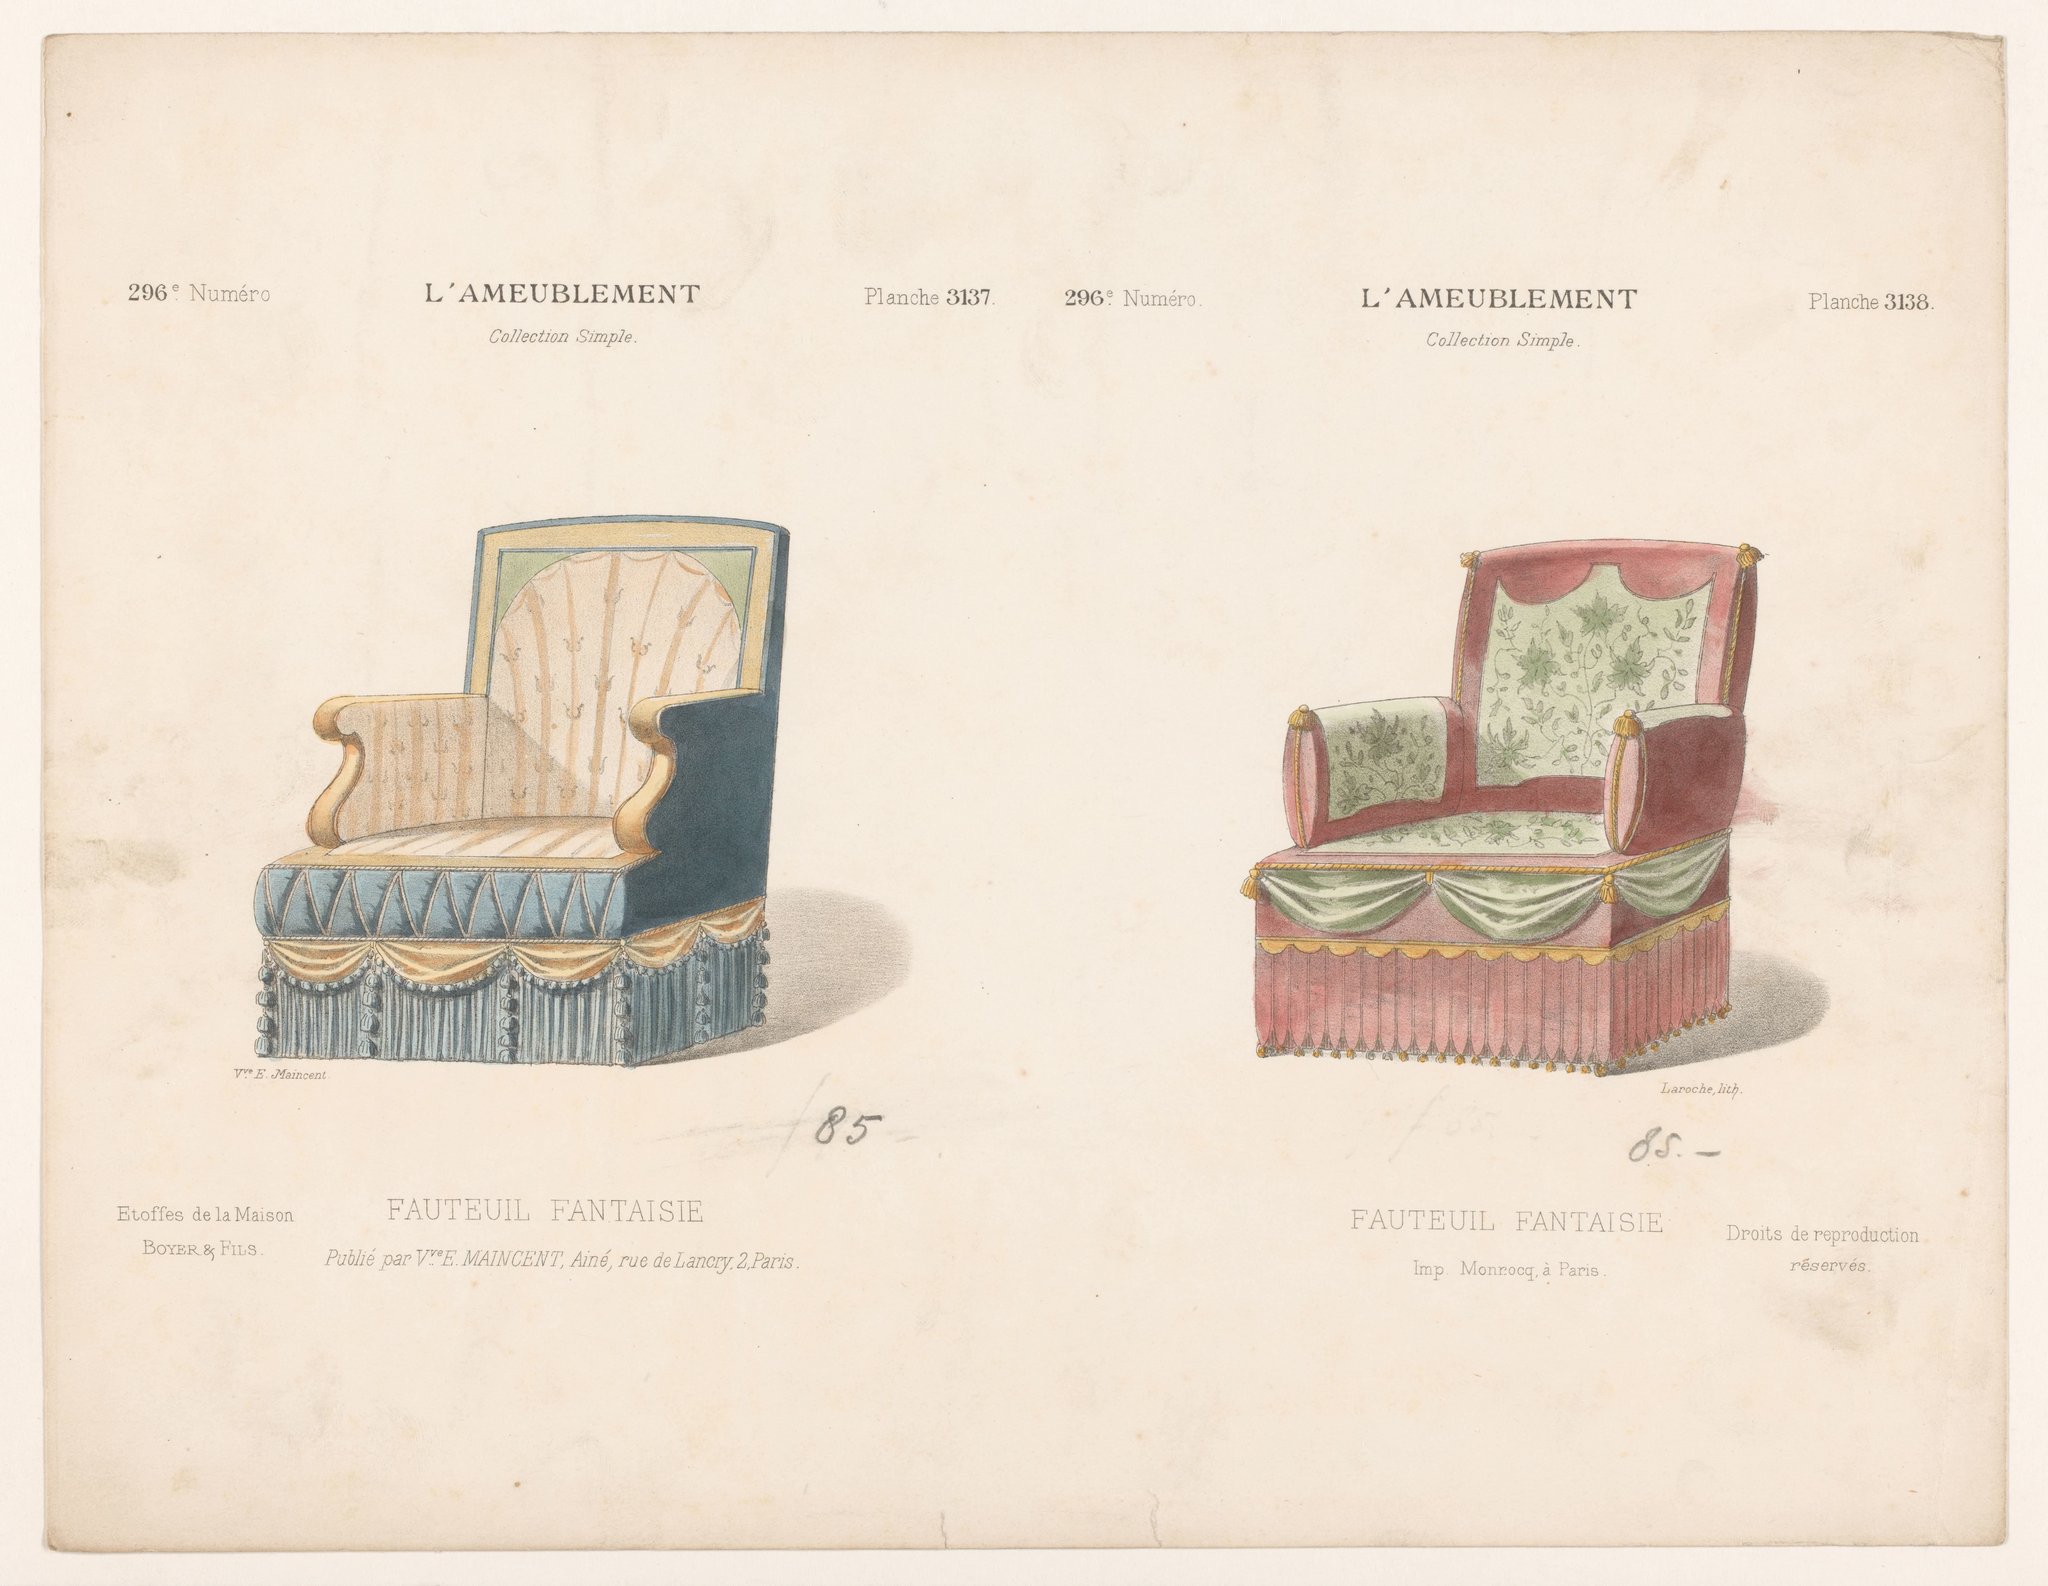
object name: print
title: L'ameublement / Collection simple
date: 1895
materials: paper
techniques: hand coloring, lithograph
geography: paris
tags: seating furniture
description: Twee fauteuils. Prent uit 296e nummer (livraison).